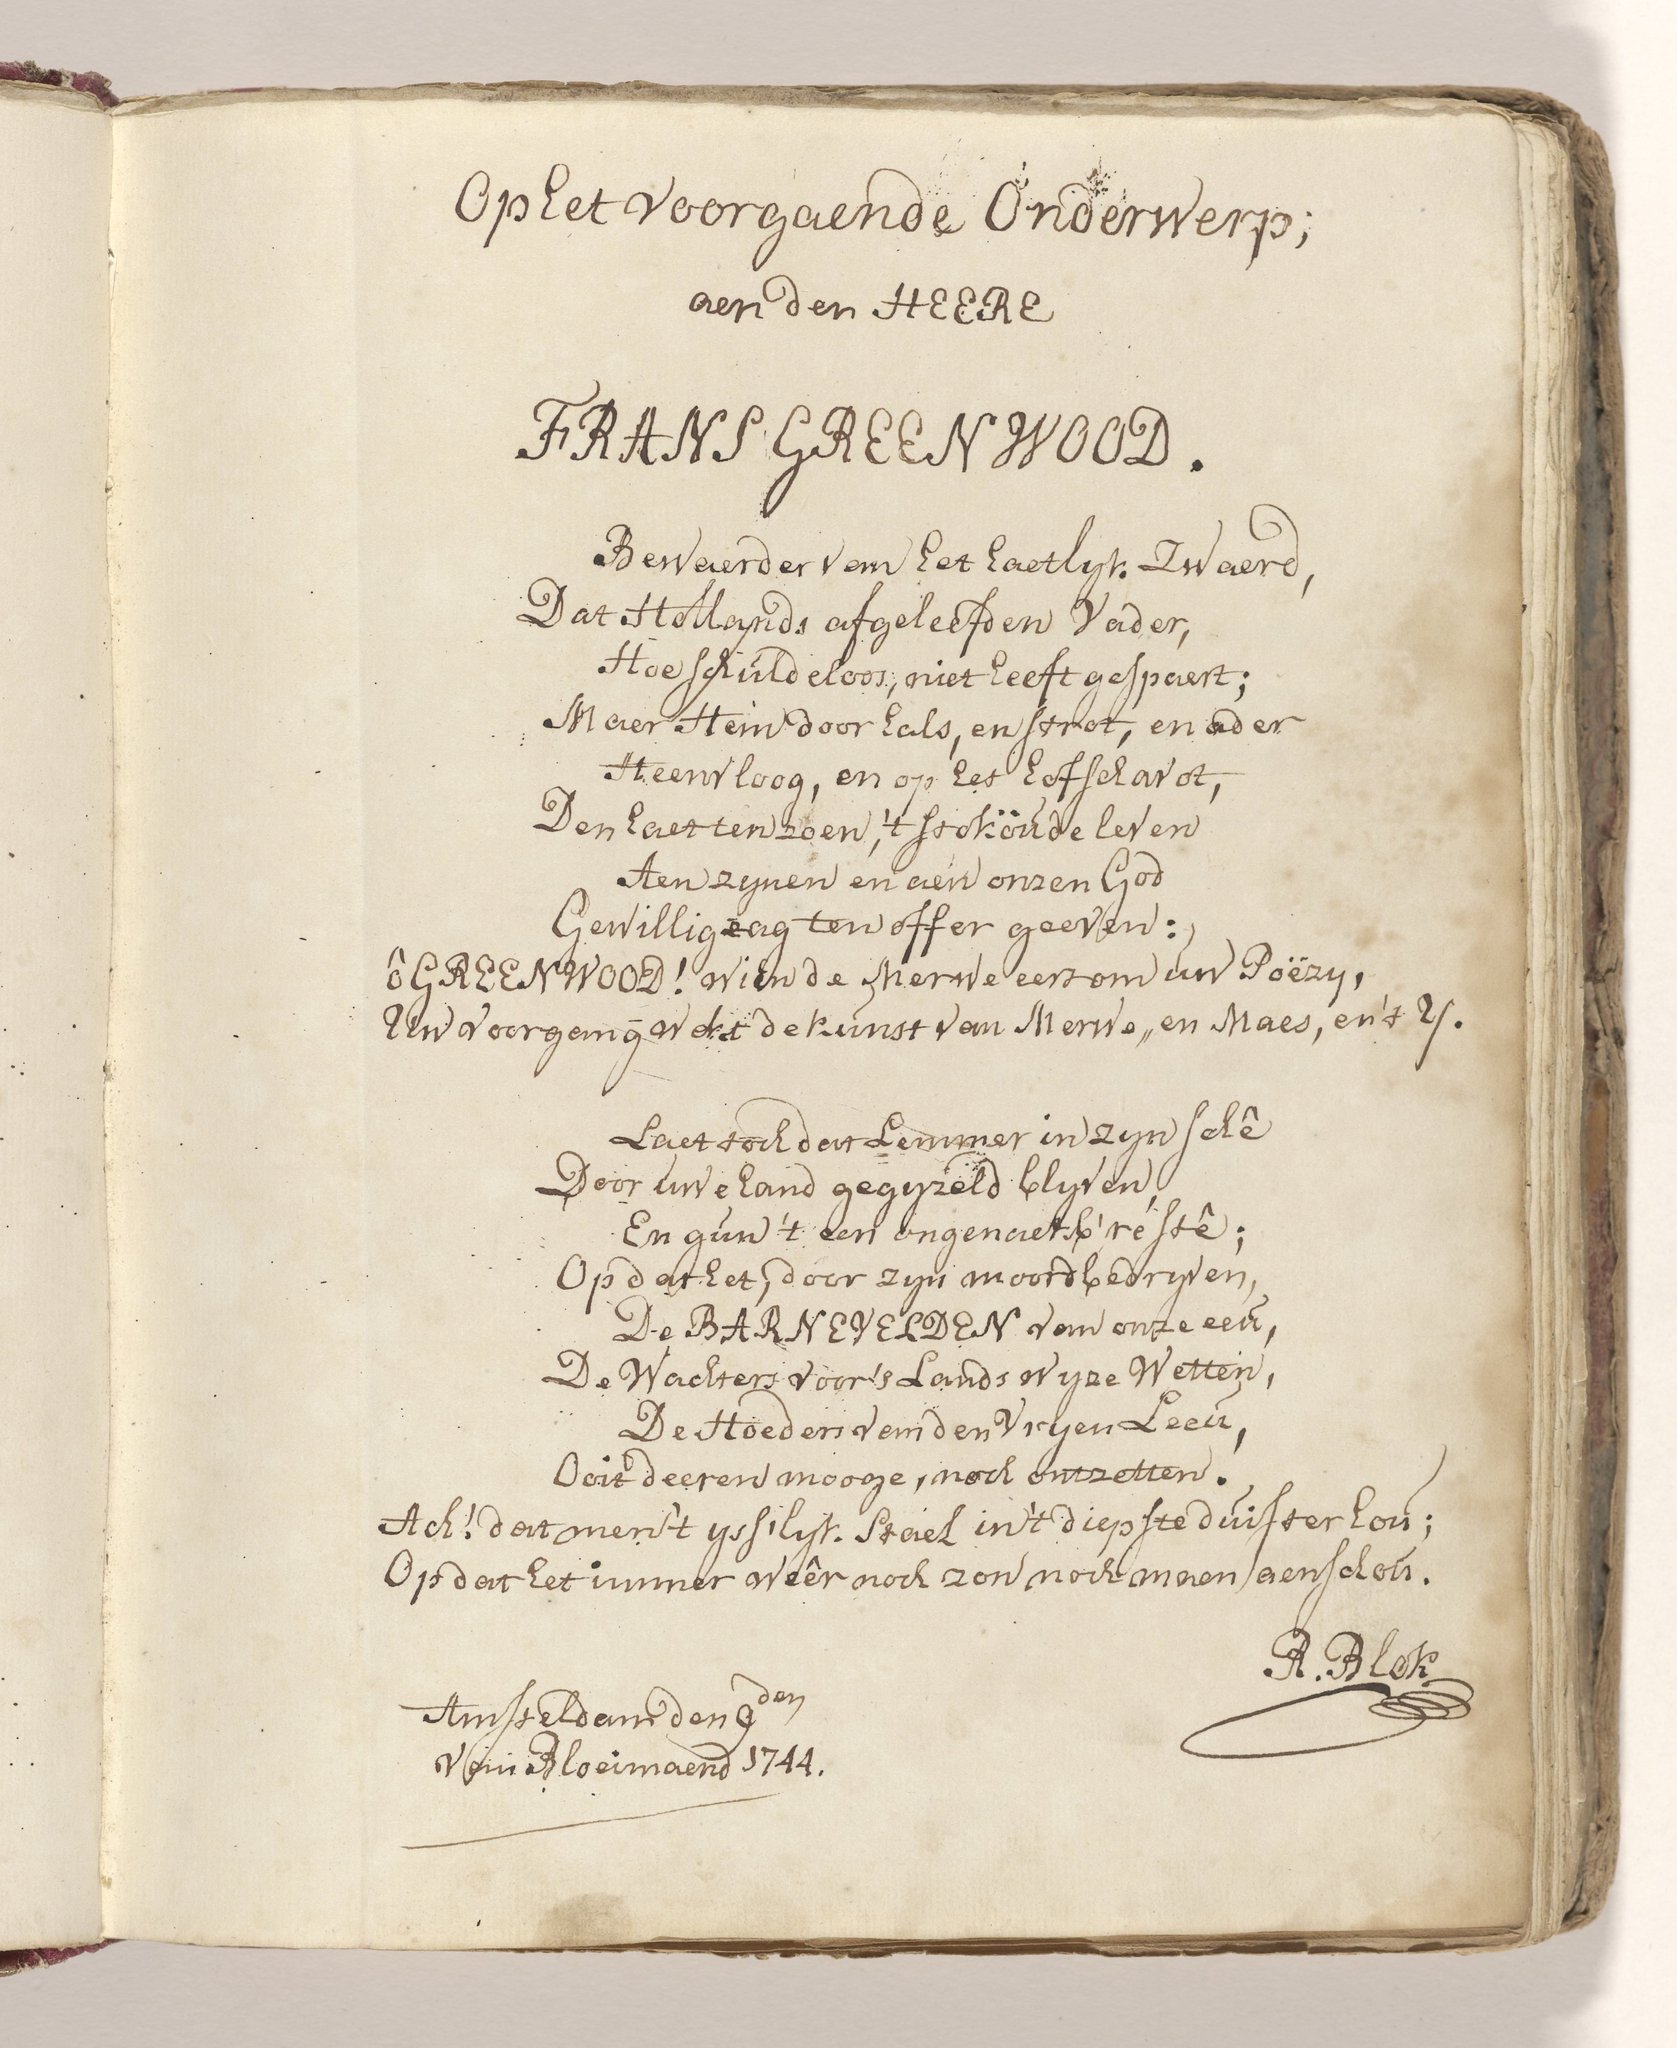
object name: manuscript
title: Op het voorgaende Onderwerp; aen den heere Frans Greenwood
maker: r. blok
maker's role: dichter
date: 1744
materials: ink, paper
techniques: writing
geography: amsterdam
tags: the hague, johan van oldenbarnevelt, rotterdam, dordrecht, frans greenwood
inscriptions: date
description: Vers van R. Blok. Onderdeel van het boek met gedichten uit de jaren 1743-1745 op het zwaard waarmee Johan van Oldenbarnevelt in 1619 zou zijn onthoofd. Het zwaard was eigendom van Frans Greenwood.